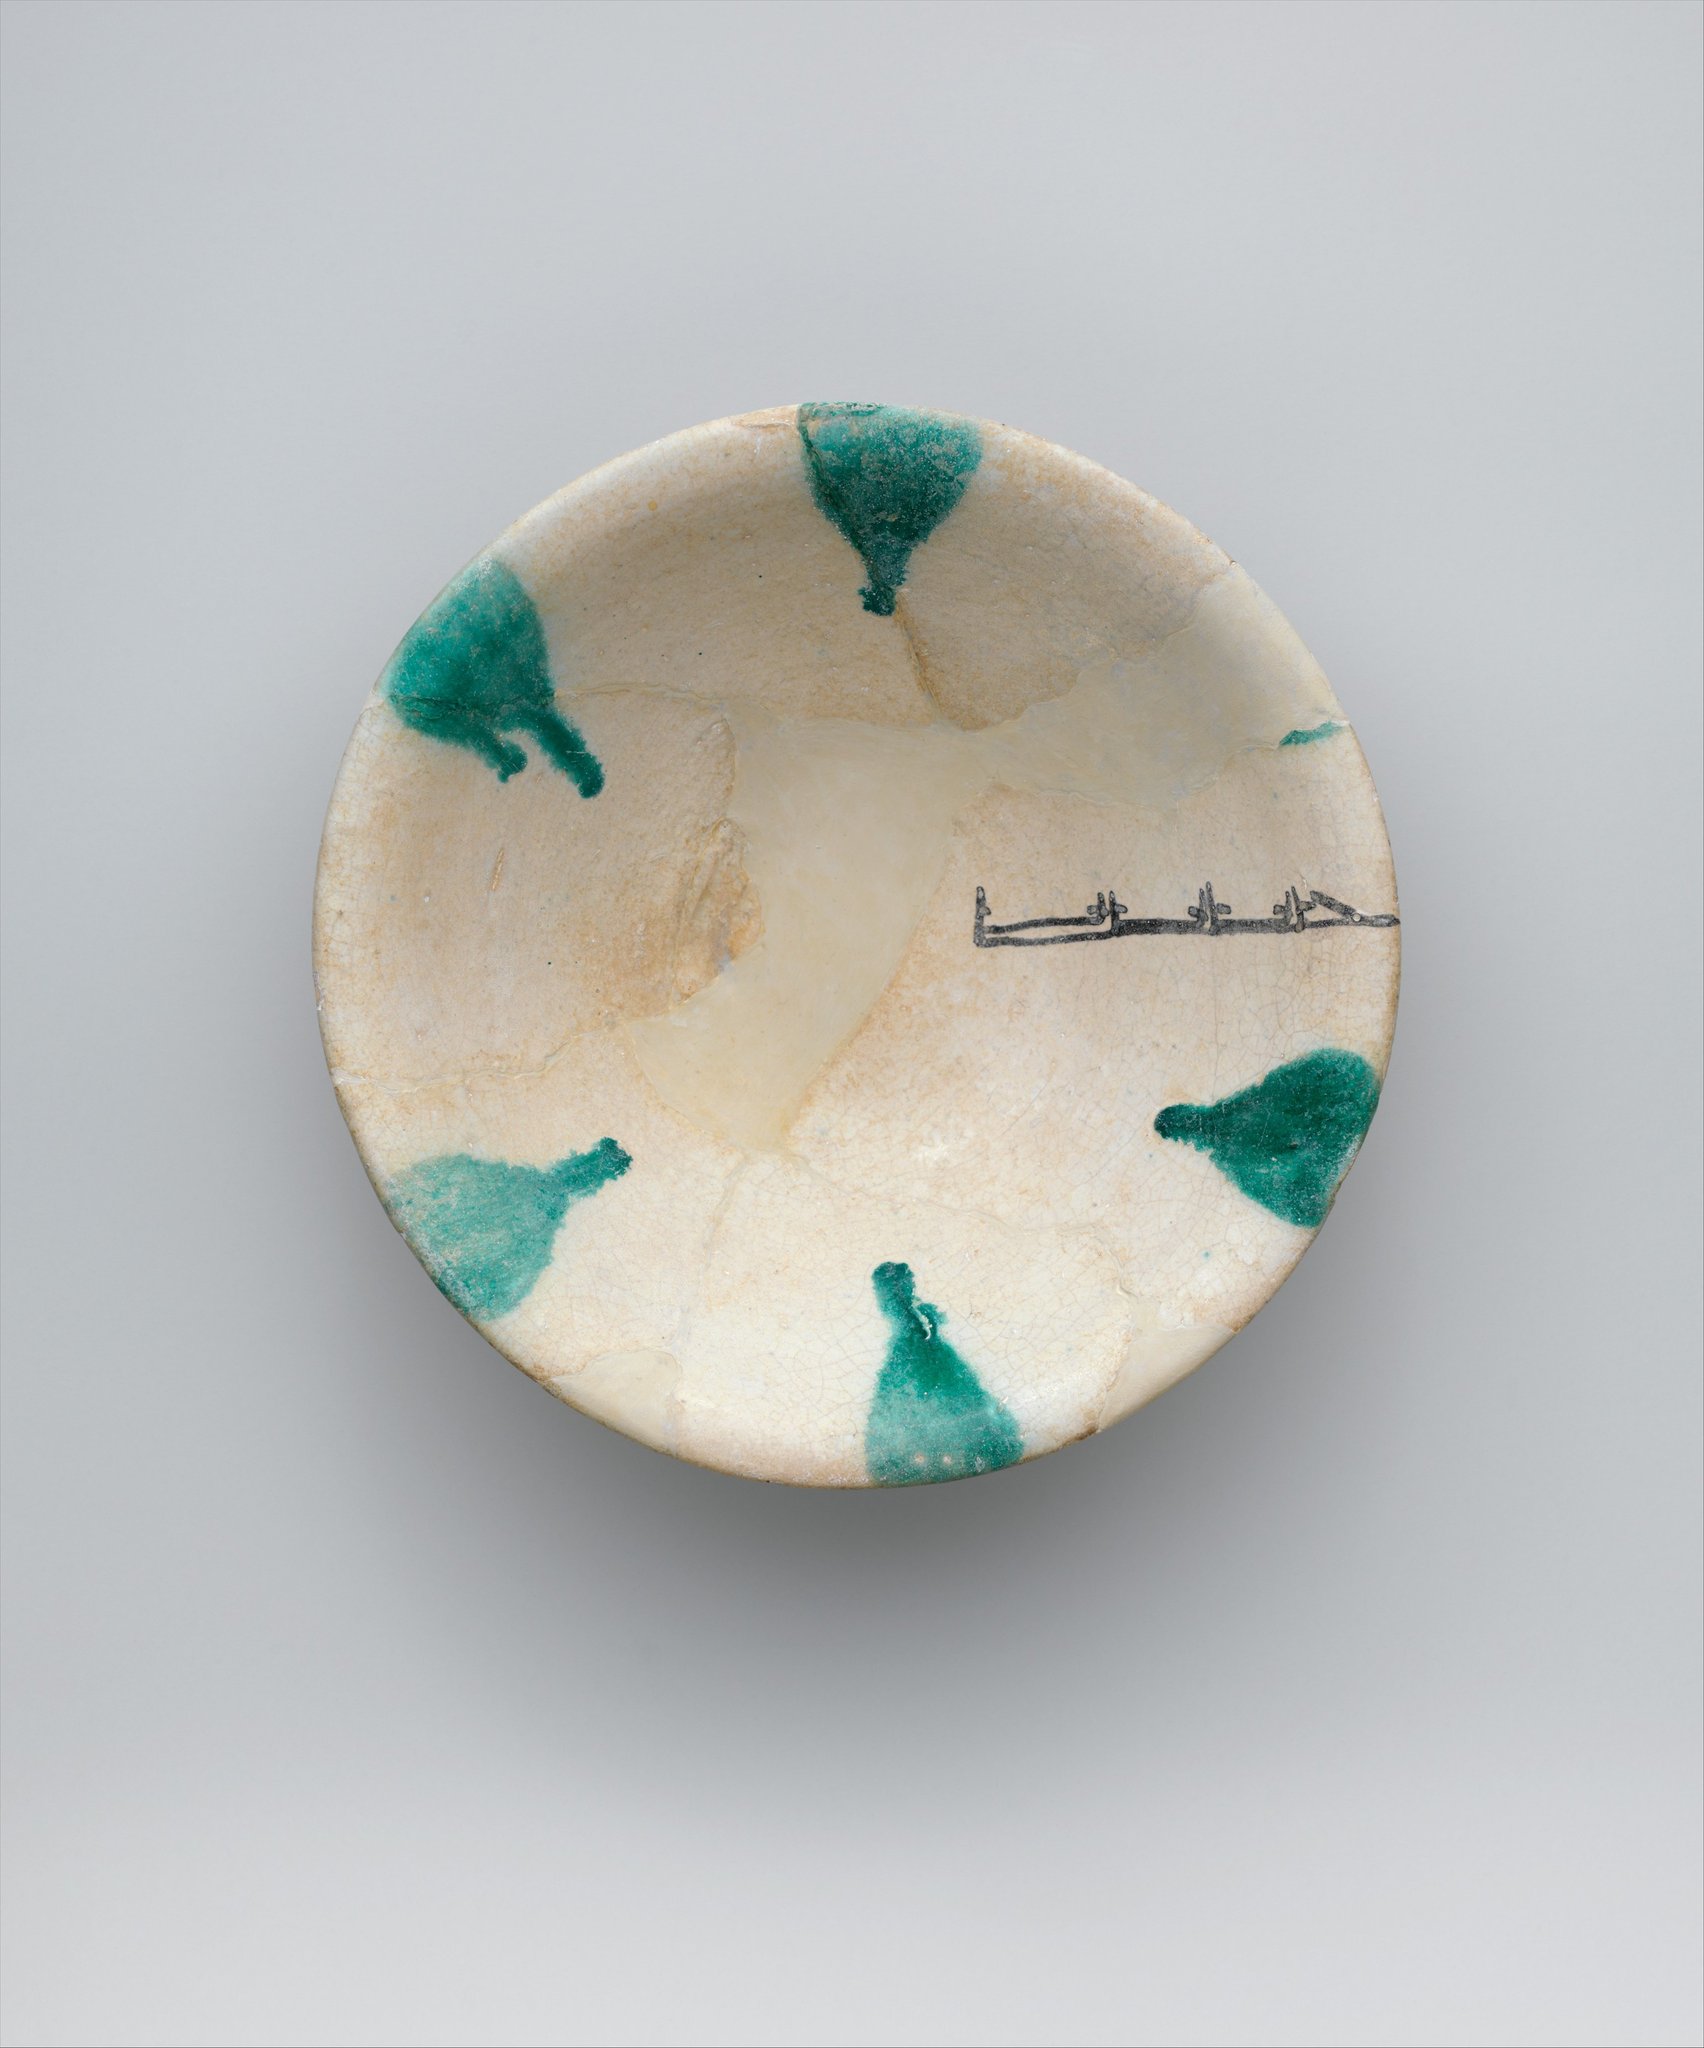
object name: bowl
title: Imitation Green-Splashed Samarra Ware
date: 801-1000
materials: earthenware, glaze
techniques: painting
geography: iran